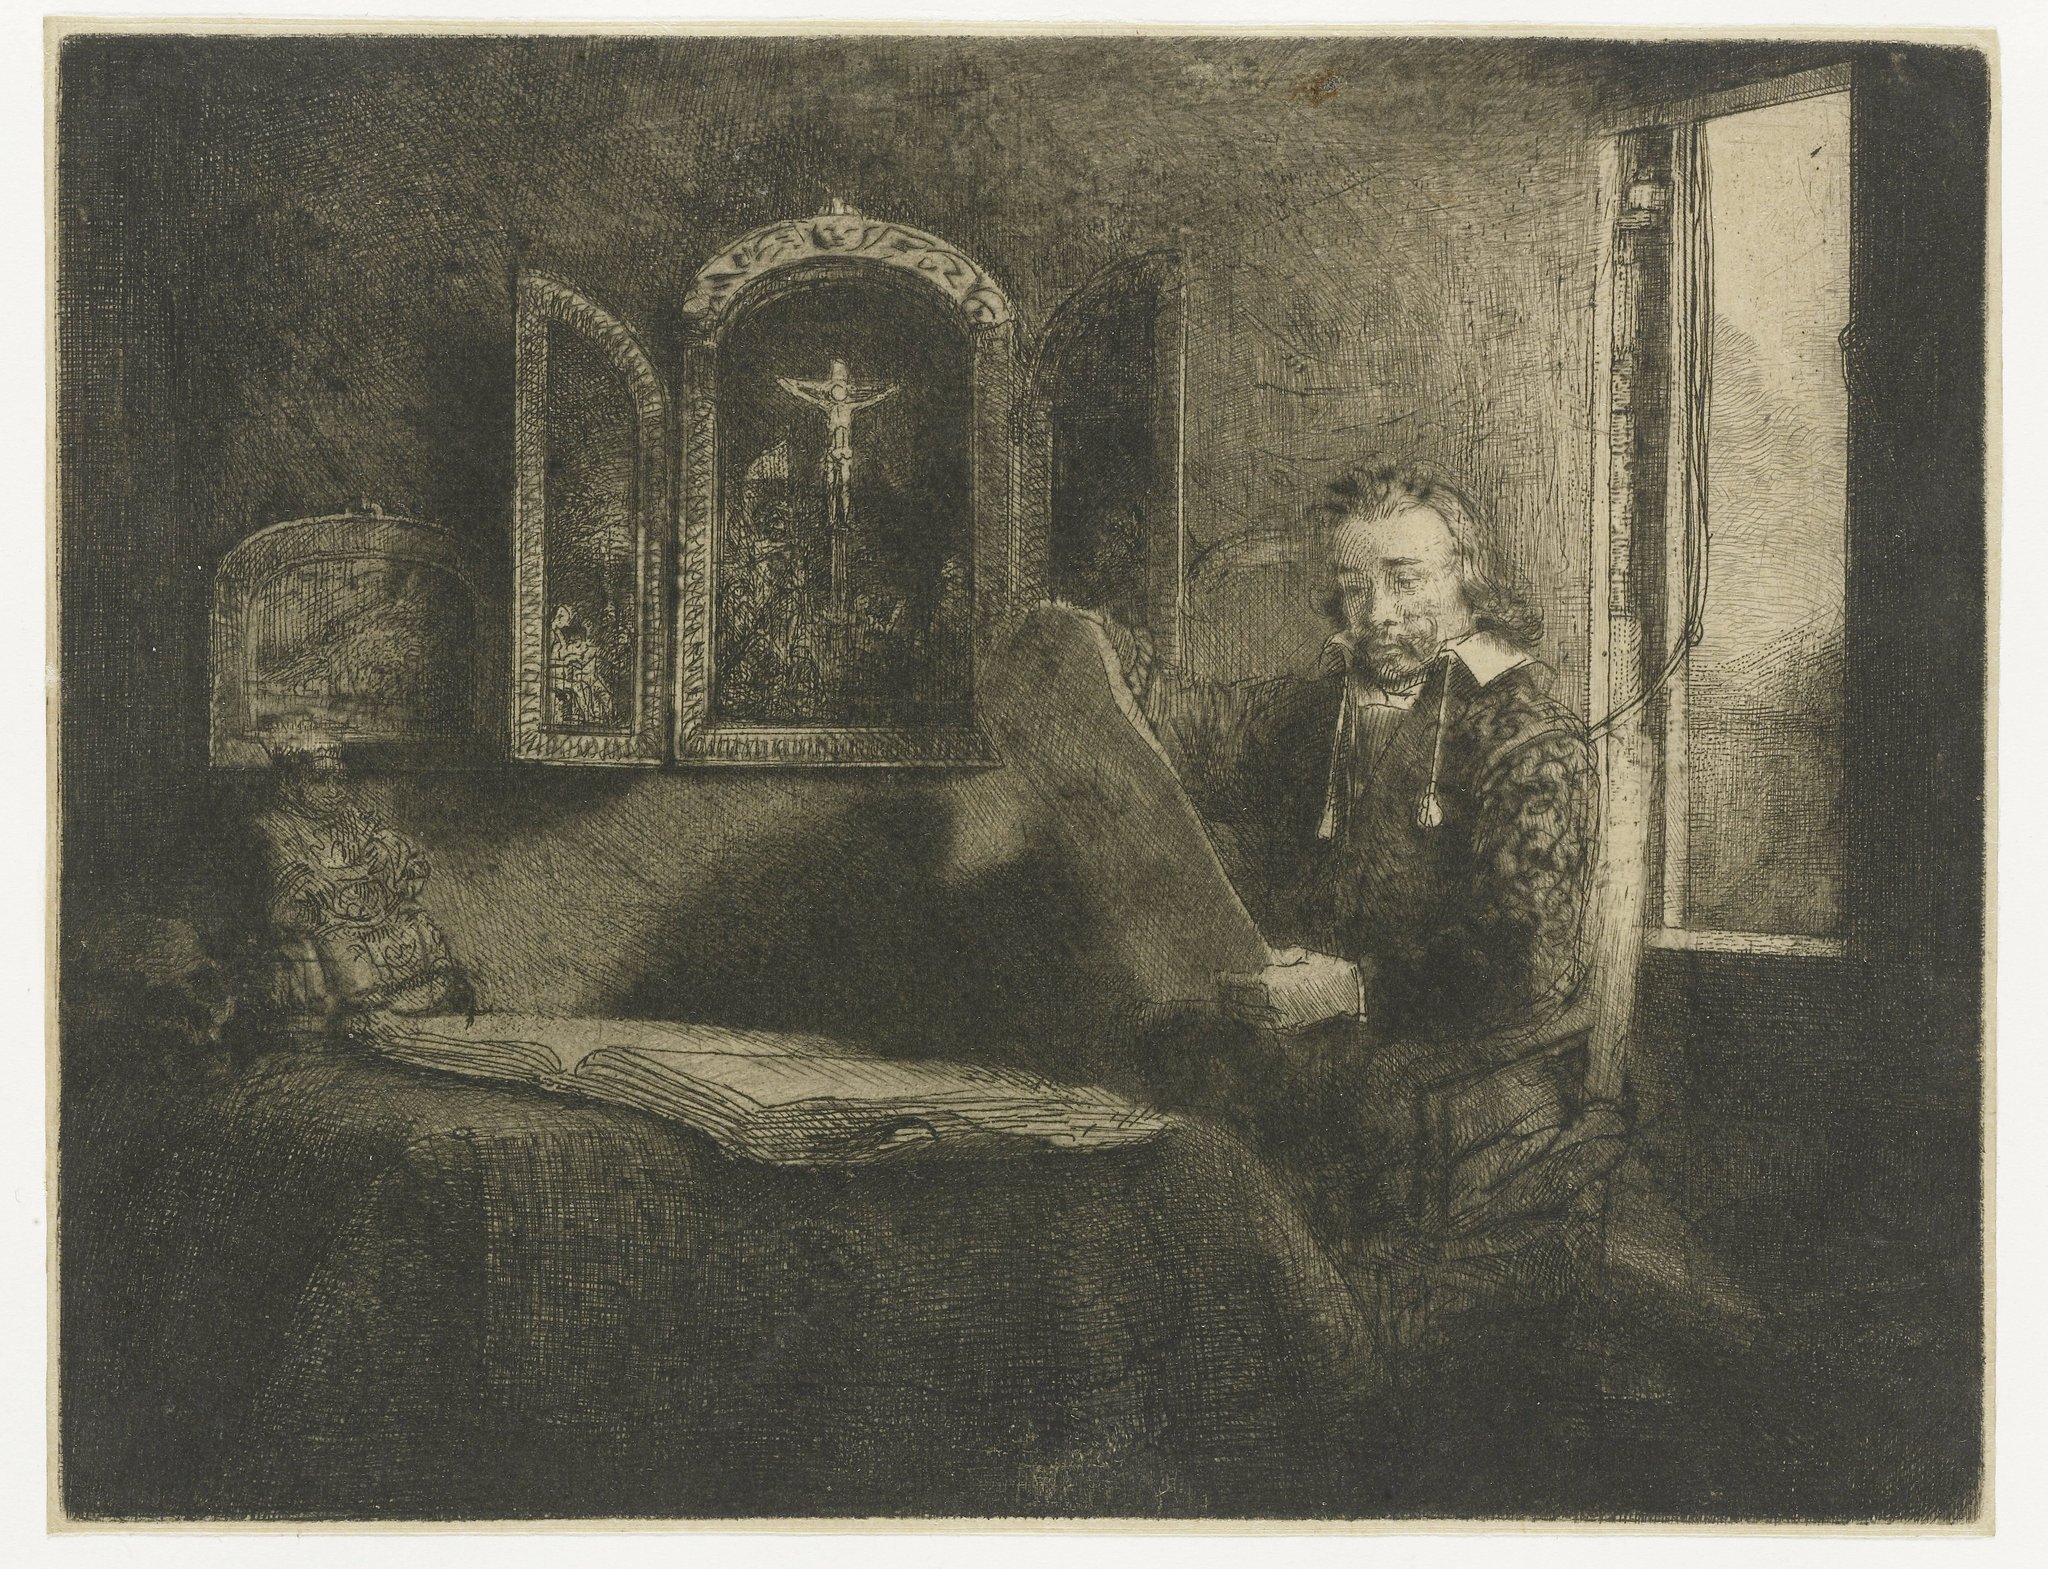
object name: print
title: Abraham Francen, apothecary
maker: rembrandt van rijn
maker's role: draughtsman, painter, print maker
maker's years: 1606-1669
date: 1657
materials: paper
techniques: drypoint, etching, intaglio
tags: kunstverzamelaar, apotheker, abraham francen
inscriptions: collector's mark: Lugt 2775, inscription: ‘proof’, inscription: ‘upright of chair (...) to window’, mark: Lugt 2228, inscription: ‘abram france’, inscription: ‘Abram France’